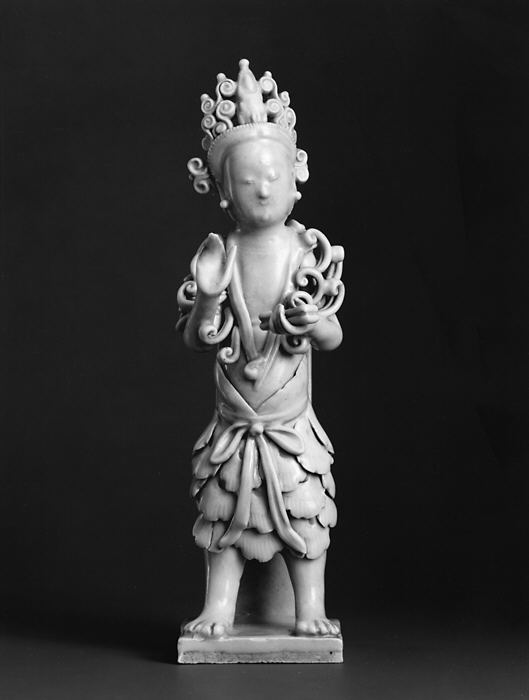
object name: figure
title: Figure of a Deity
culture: chinese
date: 1334-1366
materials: glaze, porcelain